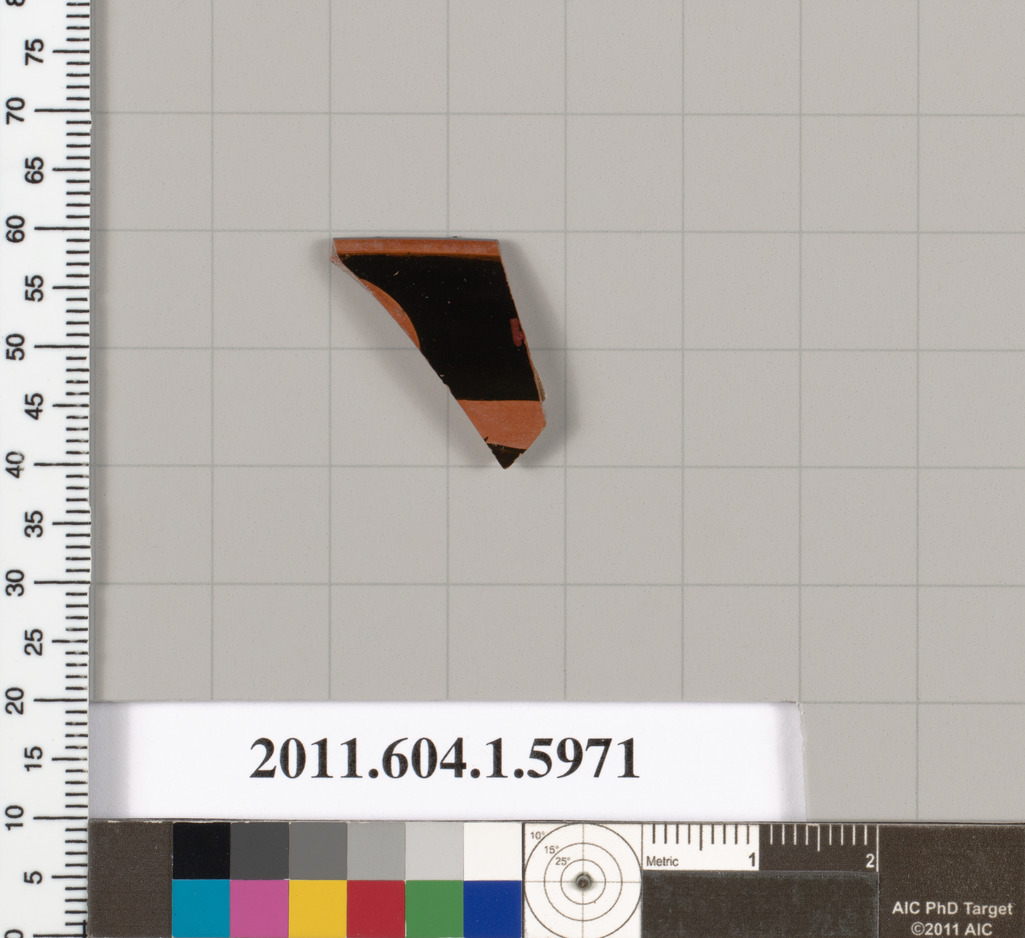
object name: kylix fragment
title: Terracotta rim fragment of a kylix (drinking cup)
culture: greek, attic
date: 433-567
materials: terracotta